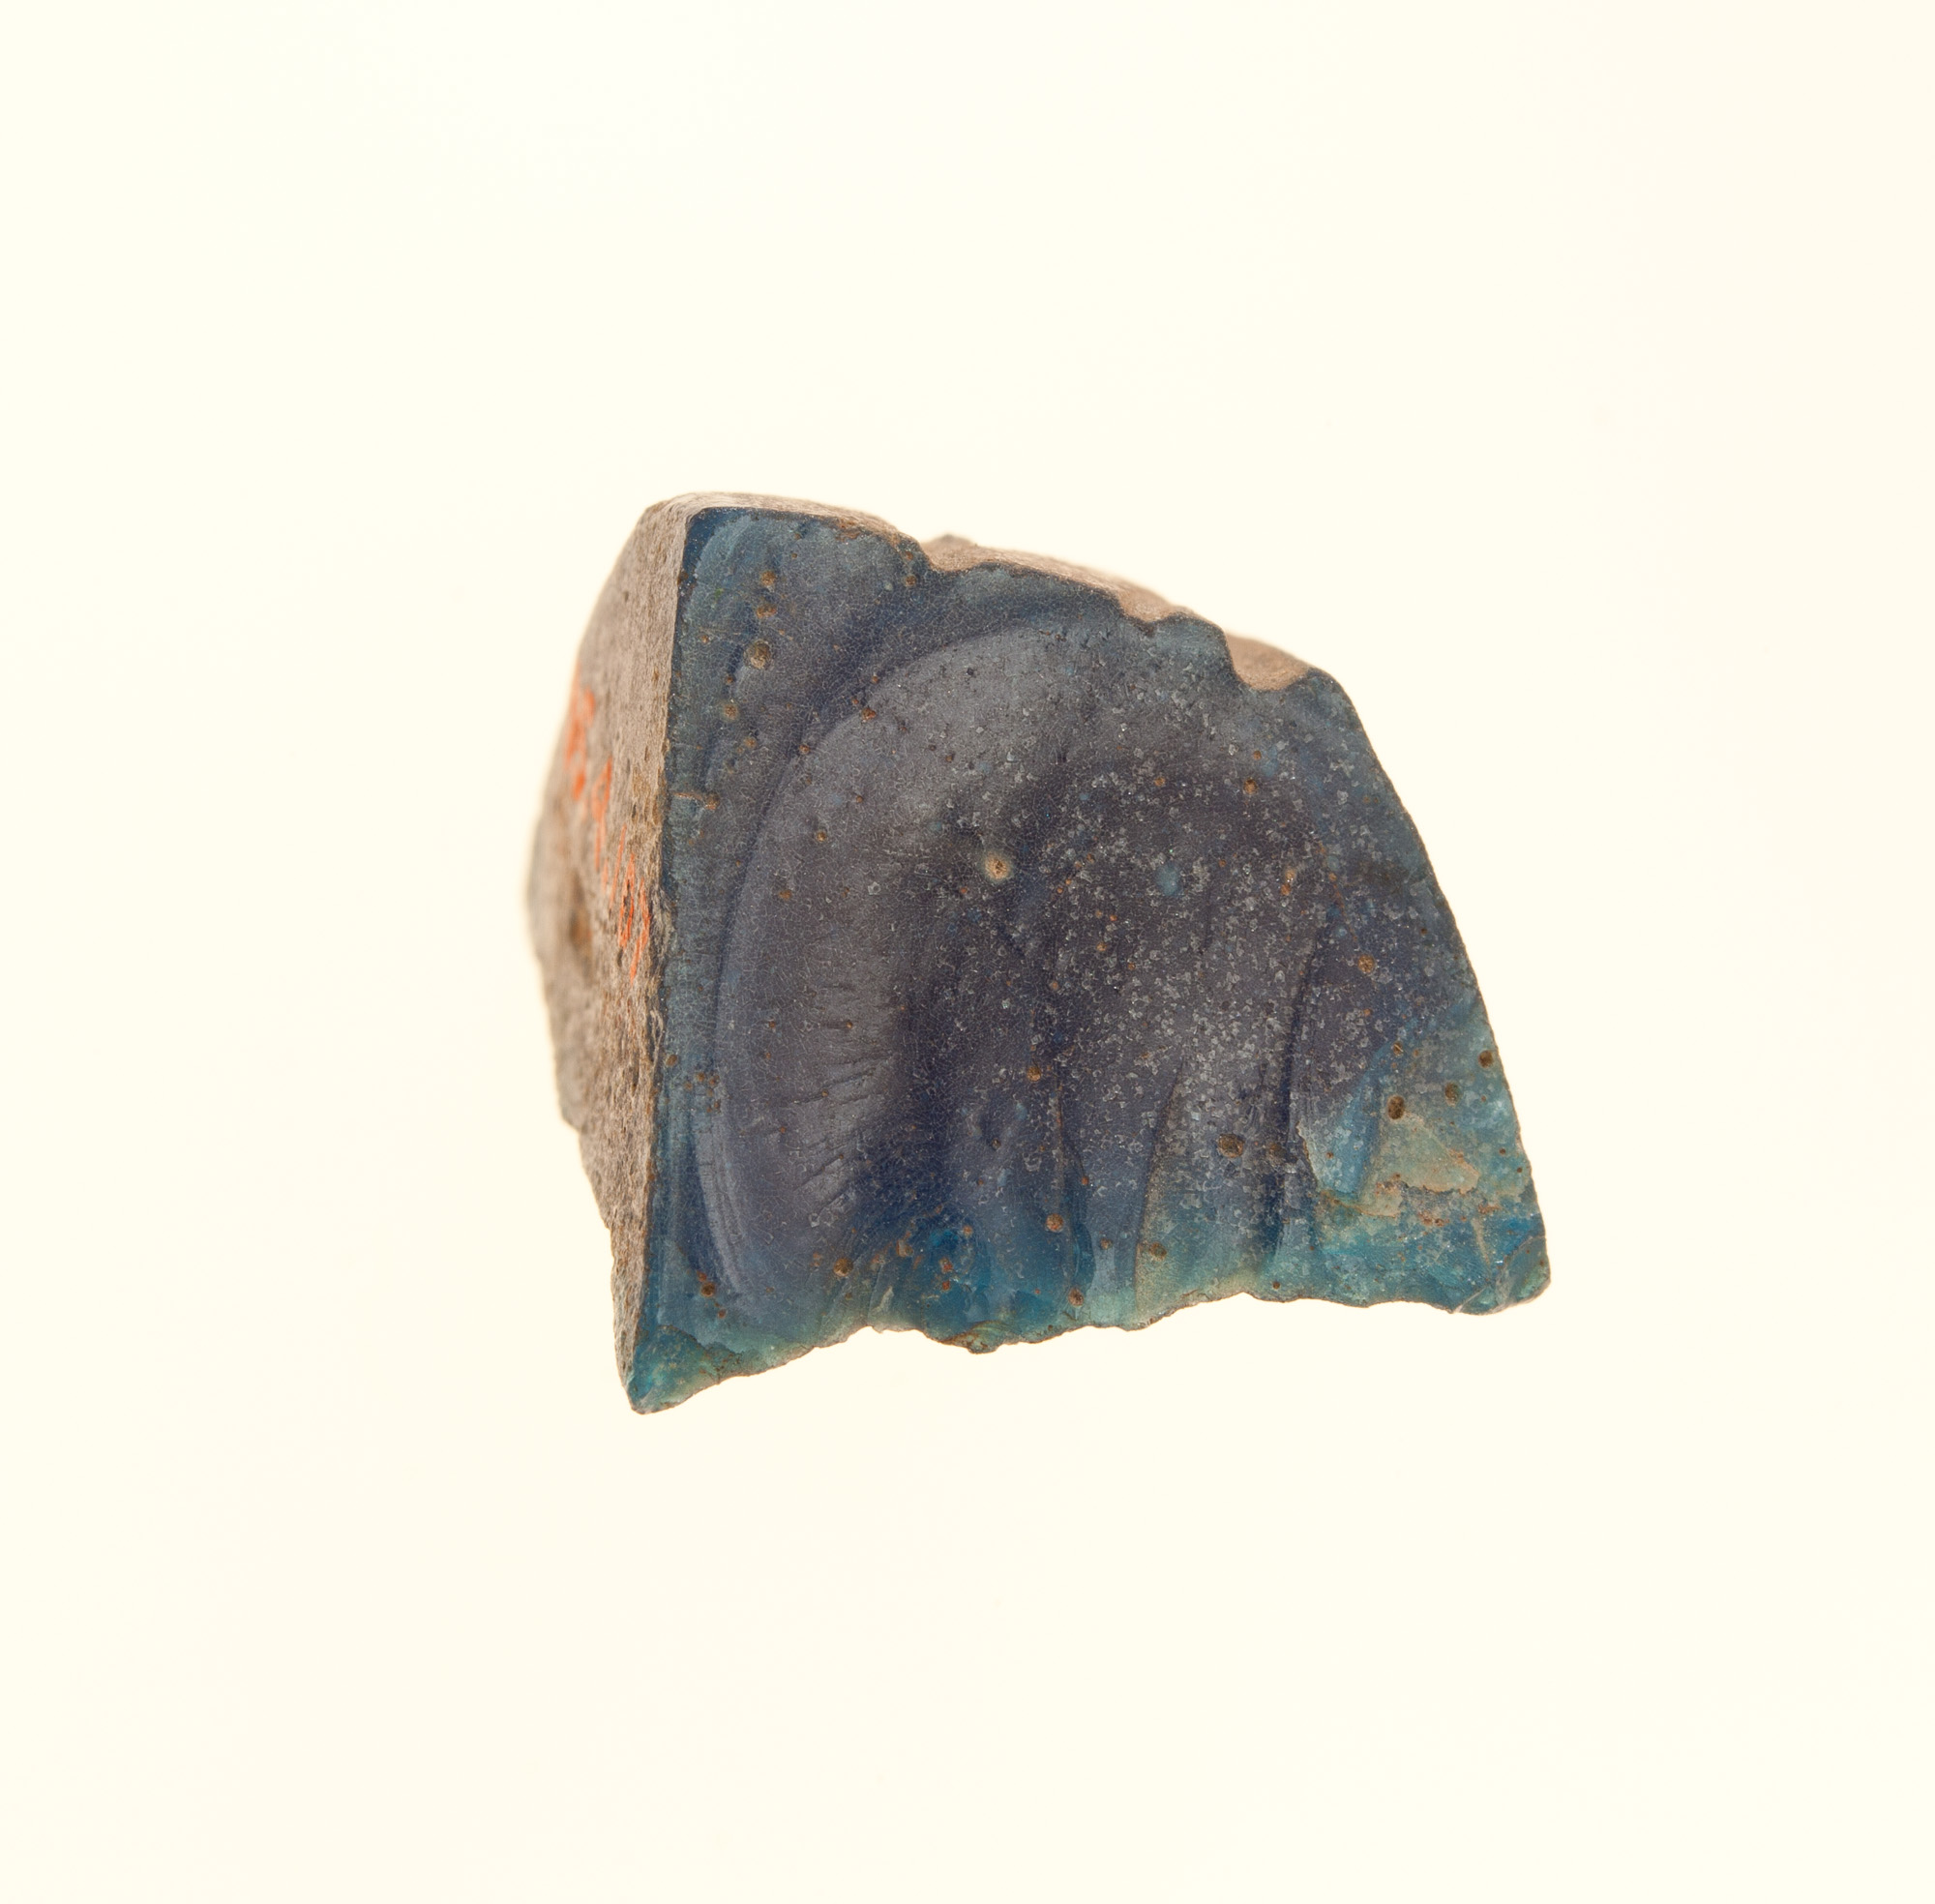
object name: glass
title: Glass Fragment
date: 1479-1458 BCE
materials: glass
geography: egypt